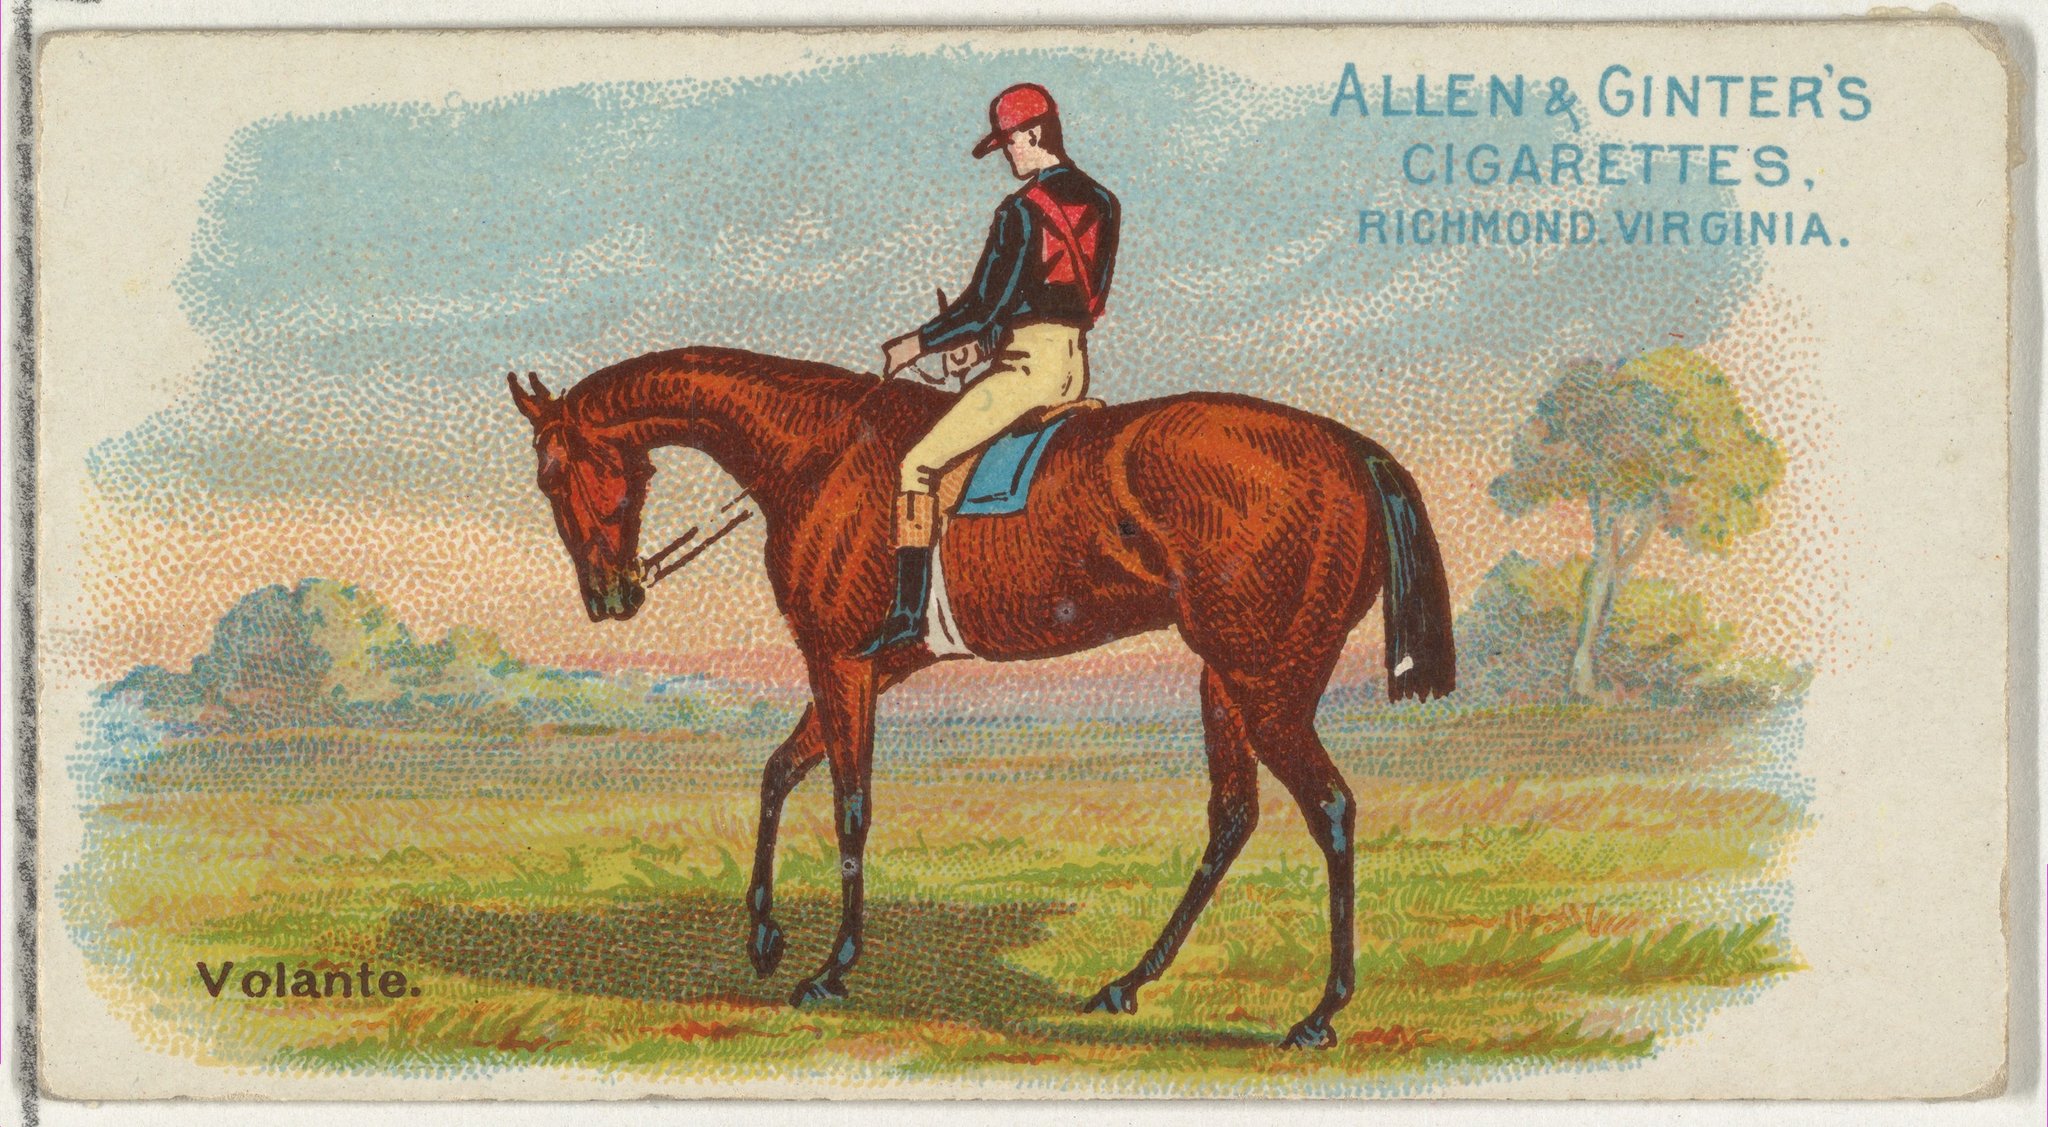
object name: print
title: Volante, from The World's Racers series (N32) for Allen & Ginter Cigarettes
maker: allen & ginter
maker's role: publisher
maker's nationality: american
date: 1888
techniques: color lithograph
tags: men,horses,jockeys